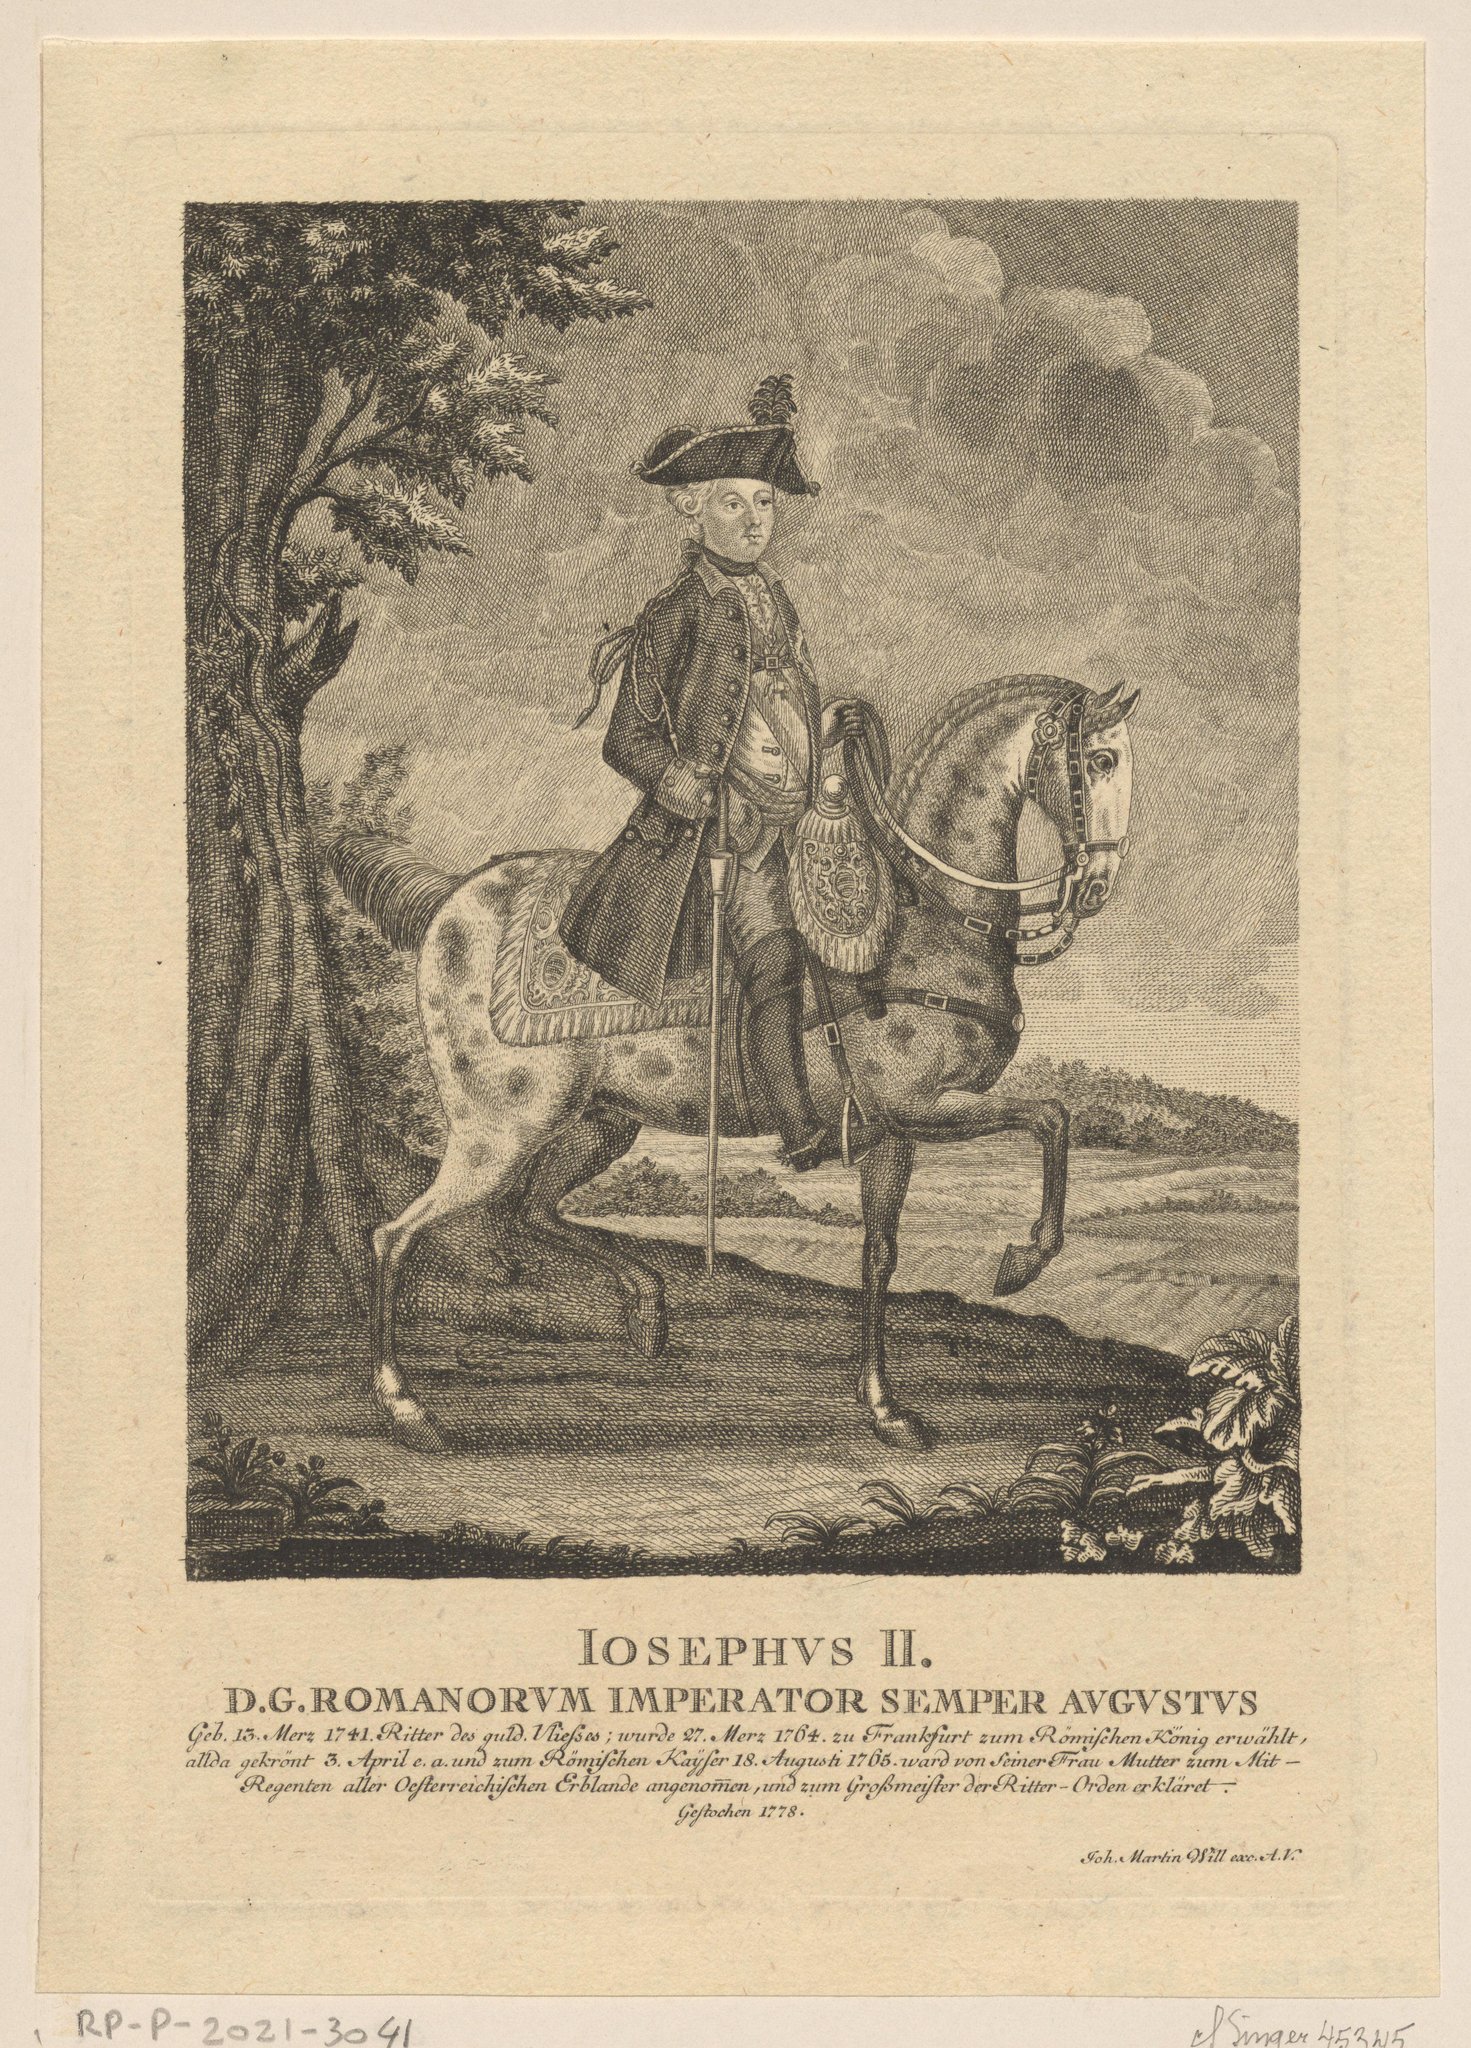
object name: print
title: Portret van Jozef II, Duits keizer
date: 1778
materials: paper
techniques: engraving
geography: augsburg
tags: vienna, jozef ii (duits keizer), equestrian state-portrait, historical persons, knighthood order of the golden fleece, emperor